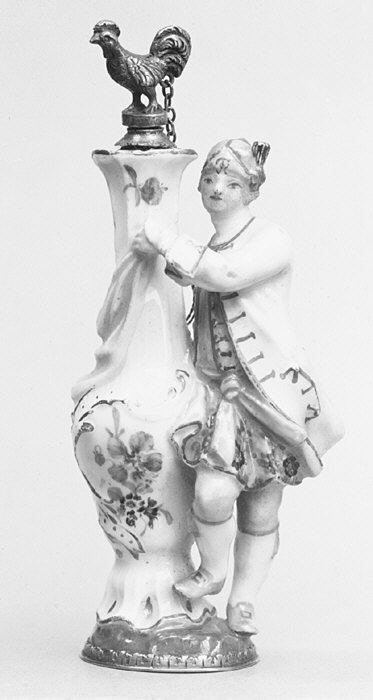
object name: scent bottle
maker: meissen manufactory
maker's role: manufactory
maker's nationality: german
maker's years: 1710-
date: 1701-1800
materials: metal, porcelain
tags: men,roosters